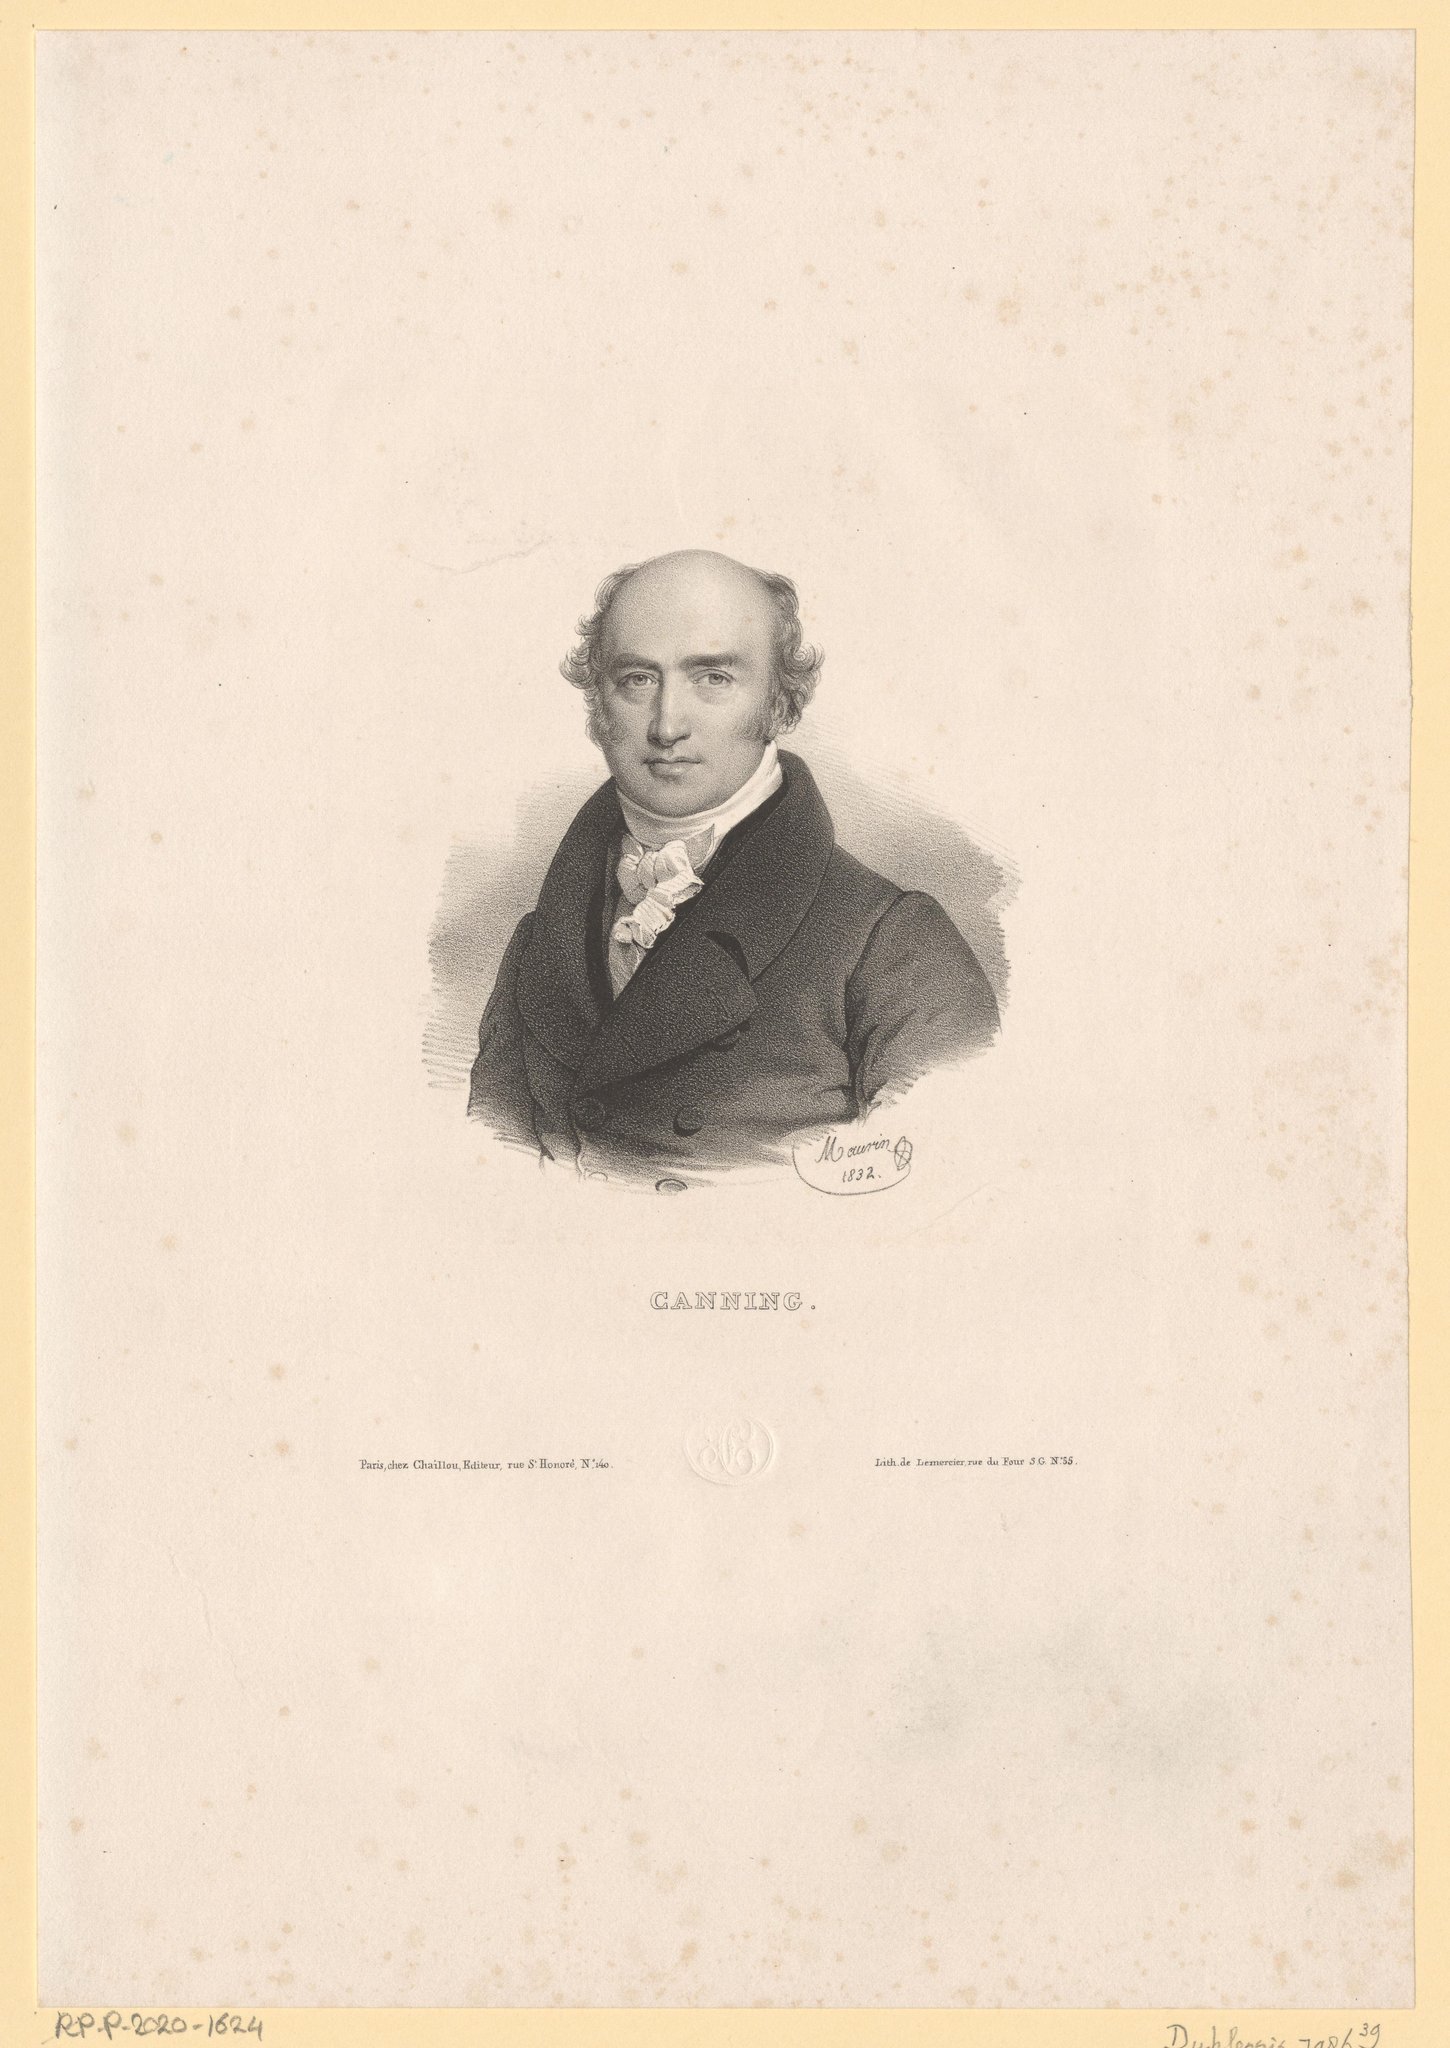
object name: print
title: Portret van George Canning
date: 1832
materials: paper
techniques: lithograph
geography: paris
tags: london, historical persons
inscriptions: check stamp: Lugt 619